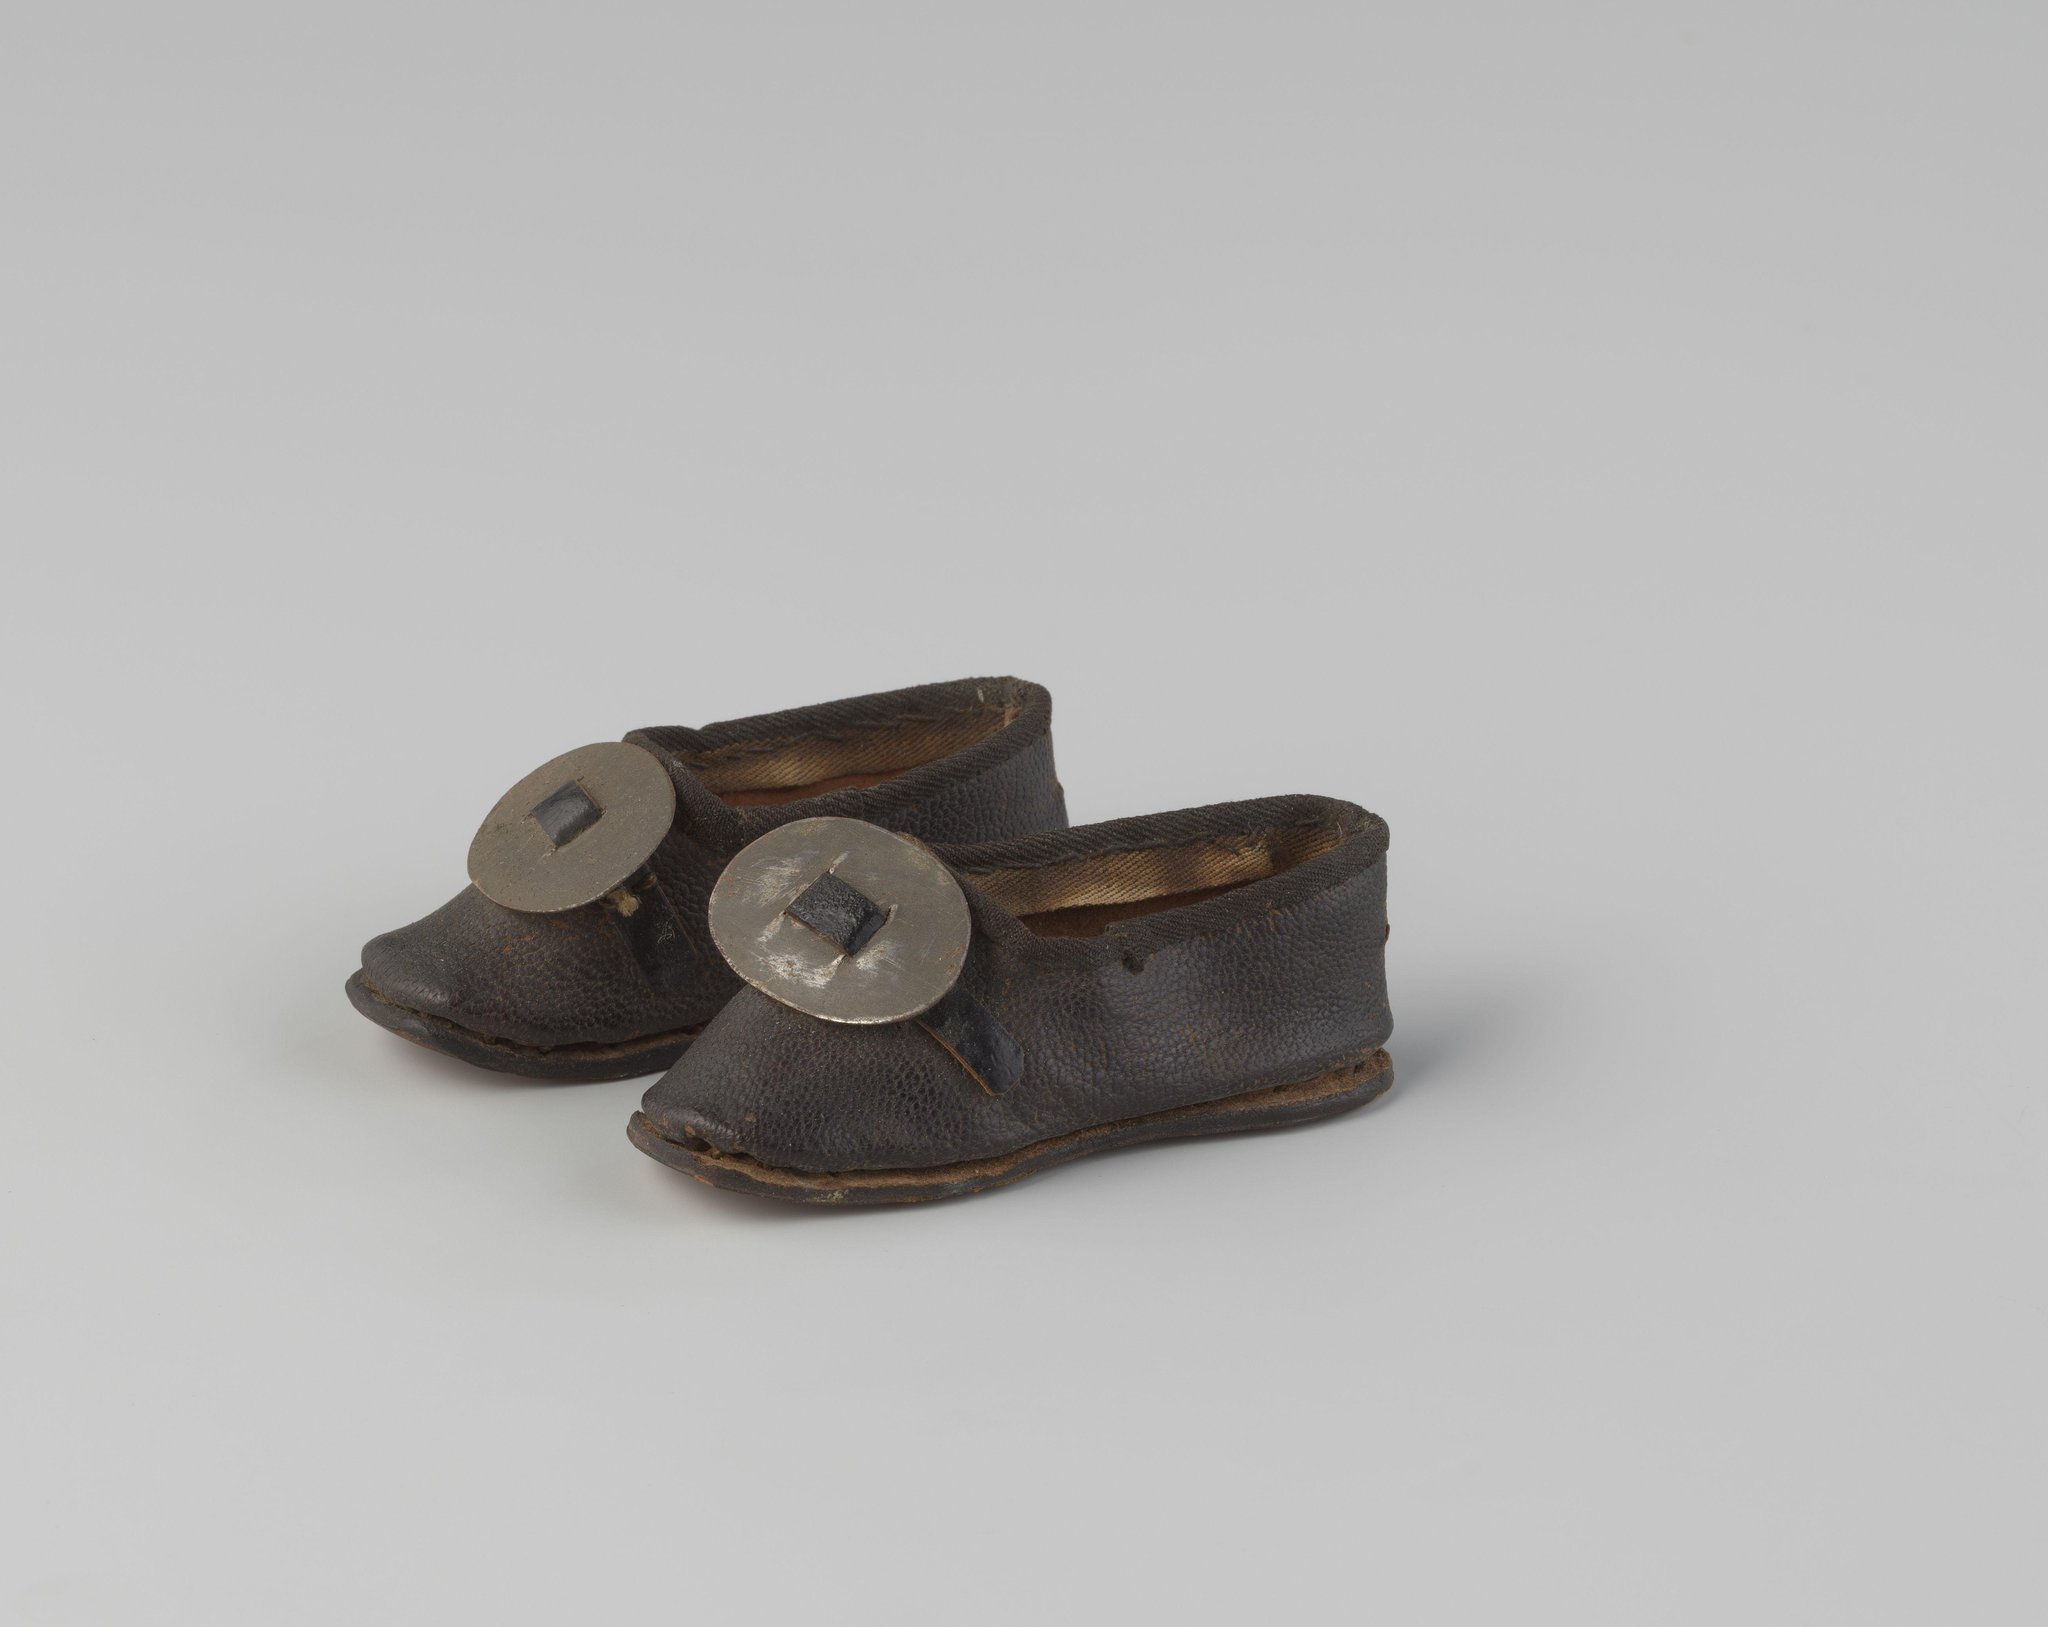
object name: poppenschoen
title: Schoen van zwart leer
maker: Anonymous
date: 1850-1940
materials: leather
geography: europe